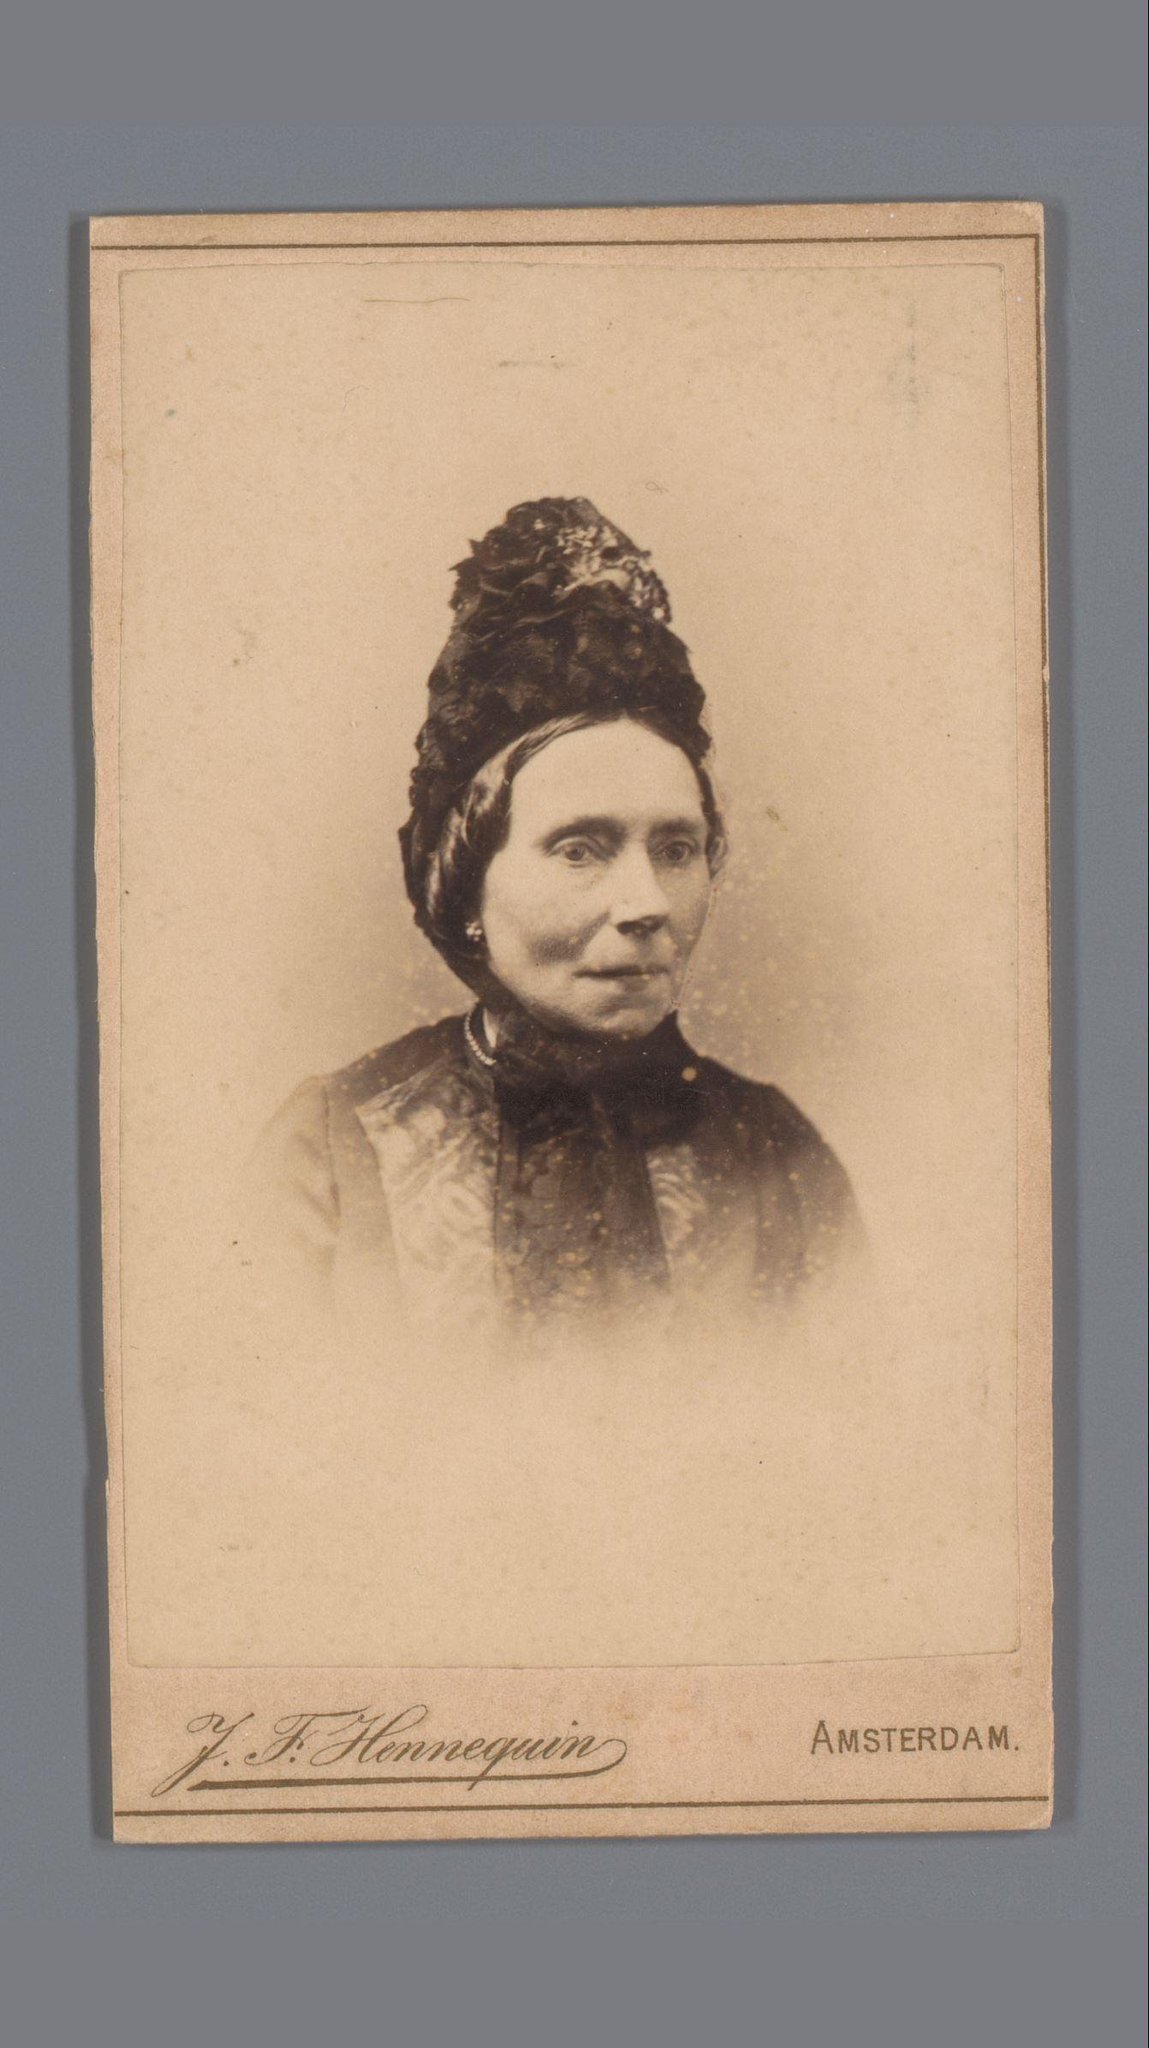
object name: photograph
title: Portret van een onbekende vrouw in klederdracht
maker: johannes franciscus hennequin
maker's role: fotograaf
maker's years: 1850-1925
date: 1880-1900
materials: cardboard, paper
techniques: albumen print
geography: amsterdam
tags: historical persons - bb - woman, head-gear: cap, folk costume, regional costume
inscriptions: inscription: ‘JFH/ ATELIER VOOR PHOTOGRAPHIE/ J. F. Hennequin/ voorheen operateur bij den Heer J.W.F. Offenberg/ Heerenstraat 24 AMSTERDAM/ De plaat blijft ter nabestelling bewaard./ MUSTERSCHUTZ A.L.’